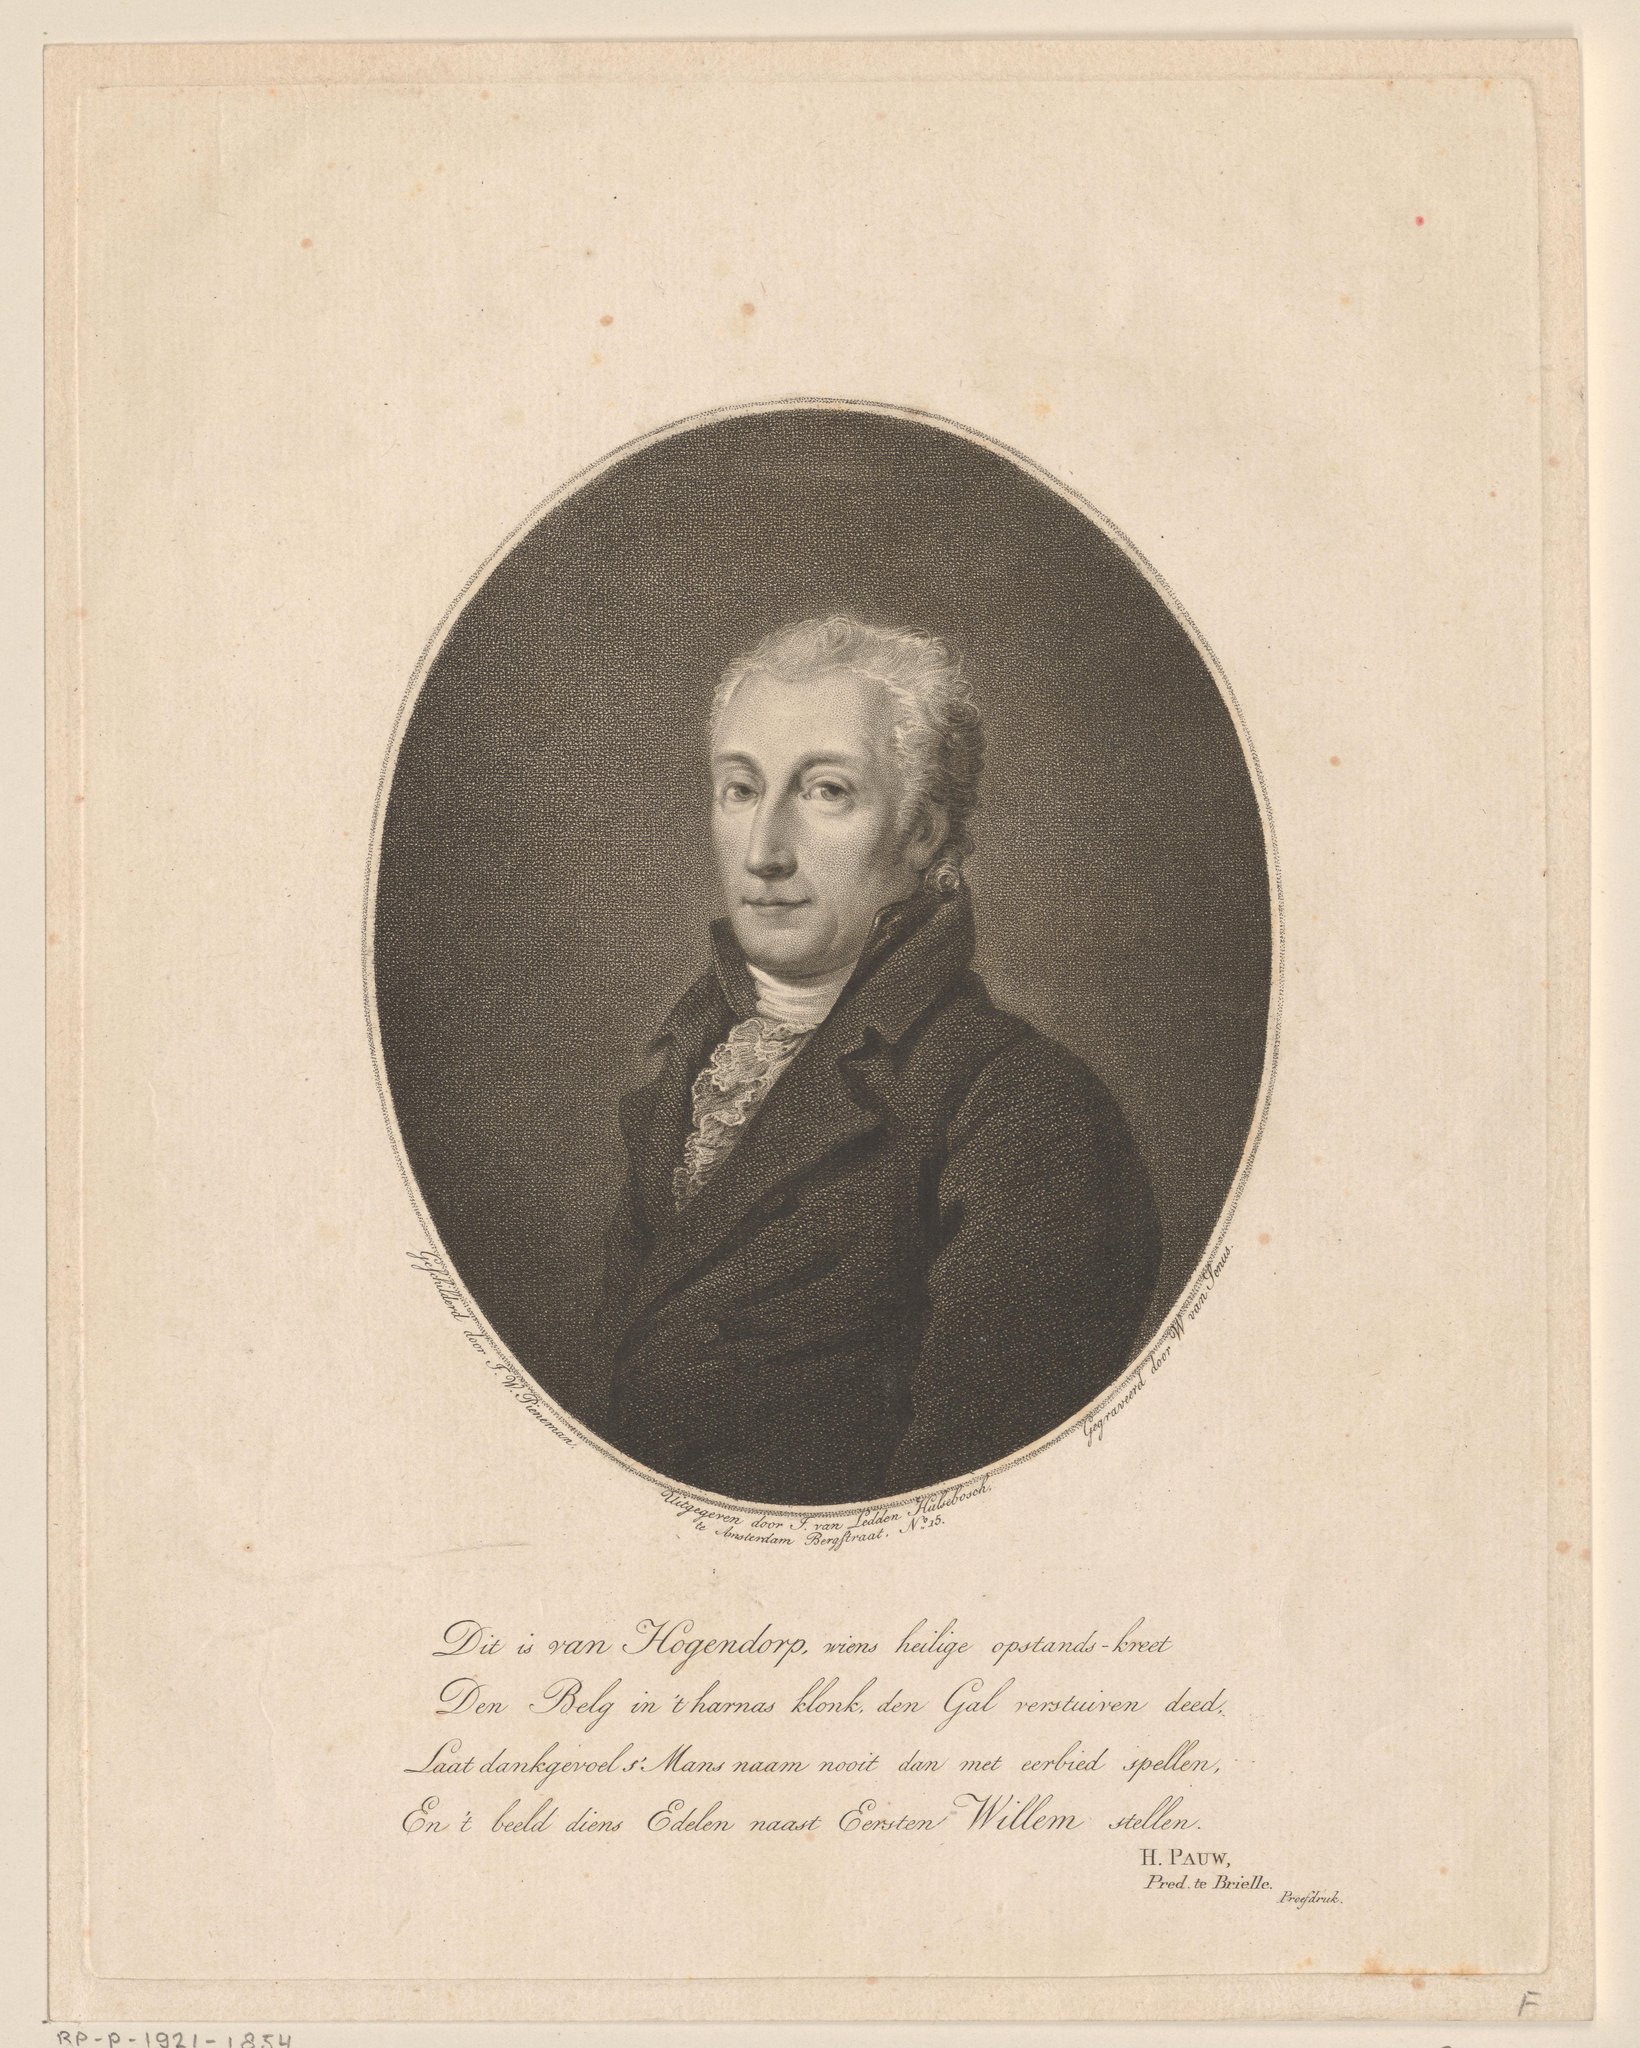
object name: print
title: Portret van Gijsbert Karel van Hogendorp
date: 1802-1819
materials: paper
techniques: engraving, etching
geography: amsterdam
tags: rotterdam, the hague, gijsbert karel graaf van hogendorp, historical persons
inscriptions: collector's mark: Lugt 2233